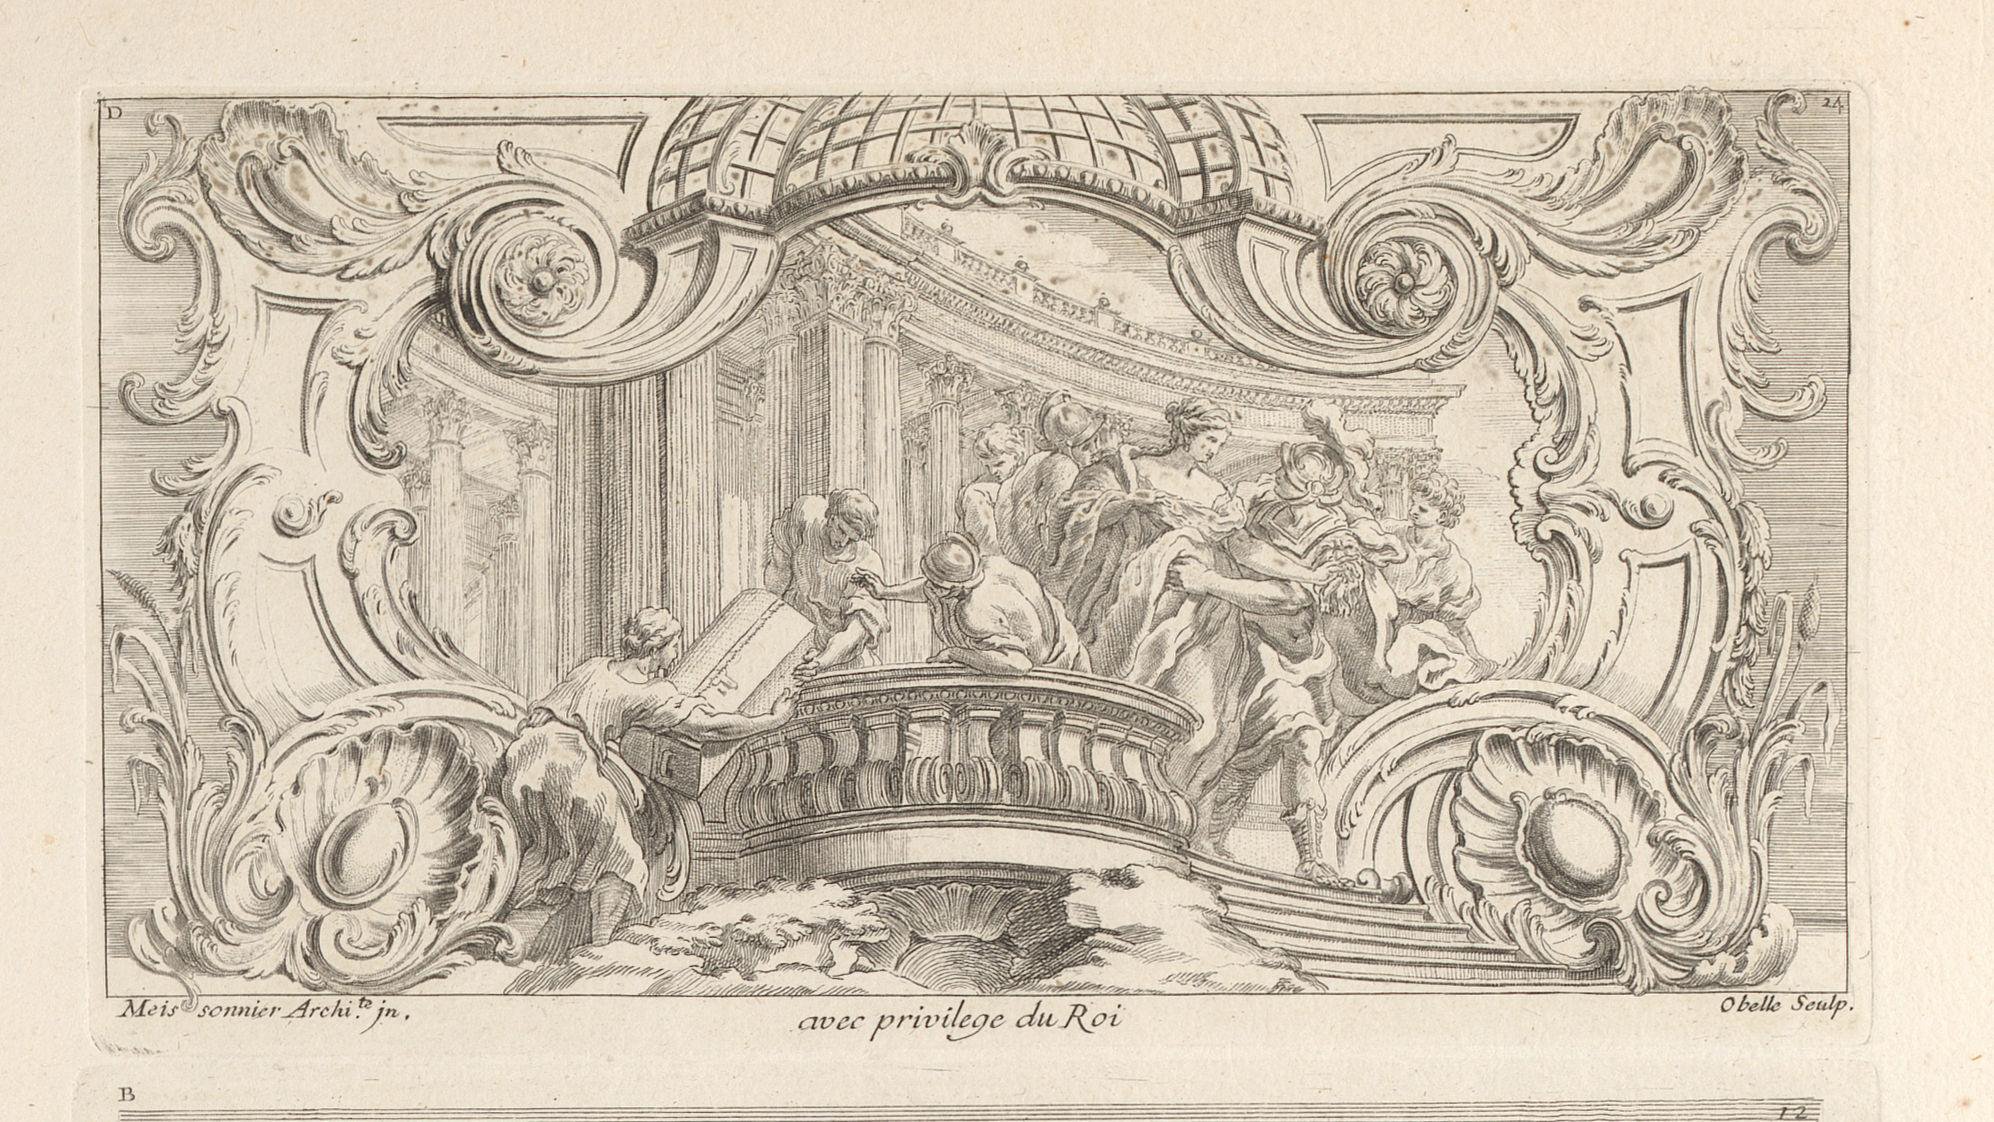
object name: album leaf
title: Werken van Juste Aurele Meissonnier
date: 1738-1749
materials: paper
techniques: etching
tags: rocaille ornament, the abduction of helen and some of her companions: paris carries them off by sea, and takes a part of the palace-treasure with him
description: Vijfde prent uit een serie van zeven rocailles.